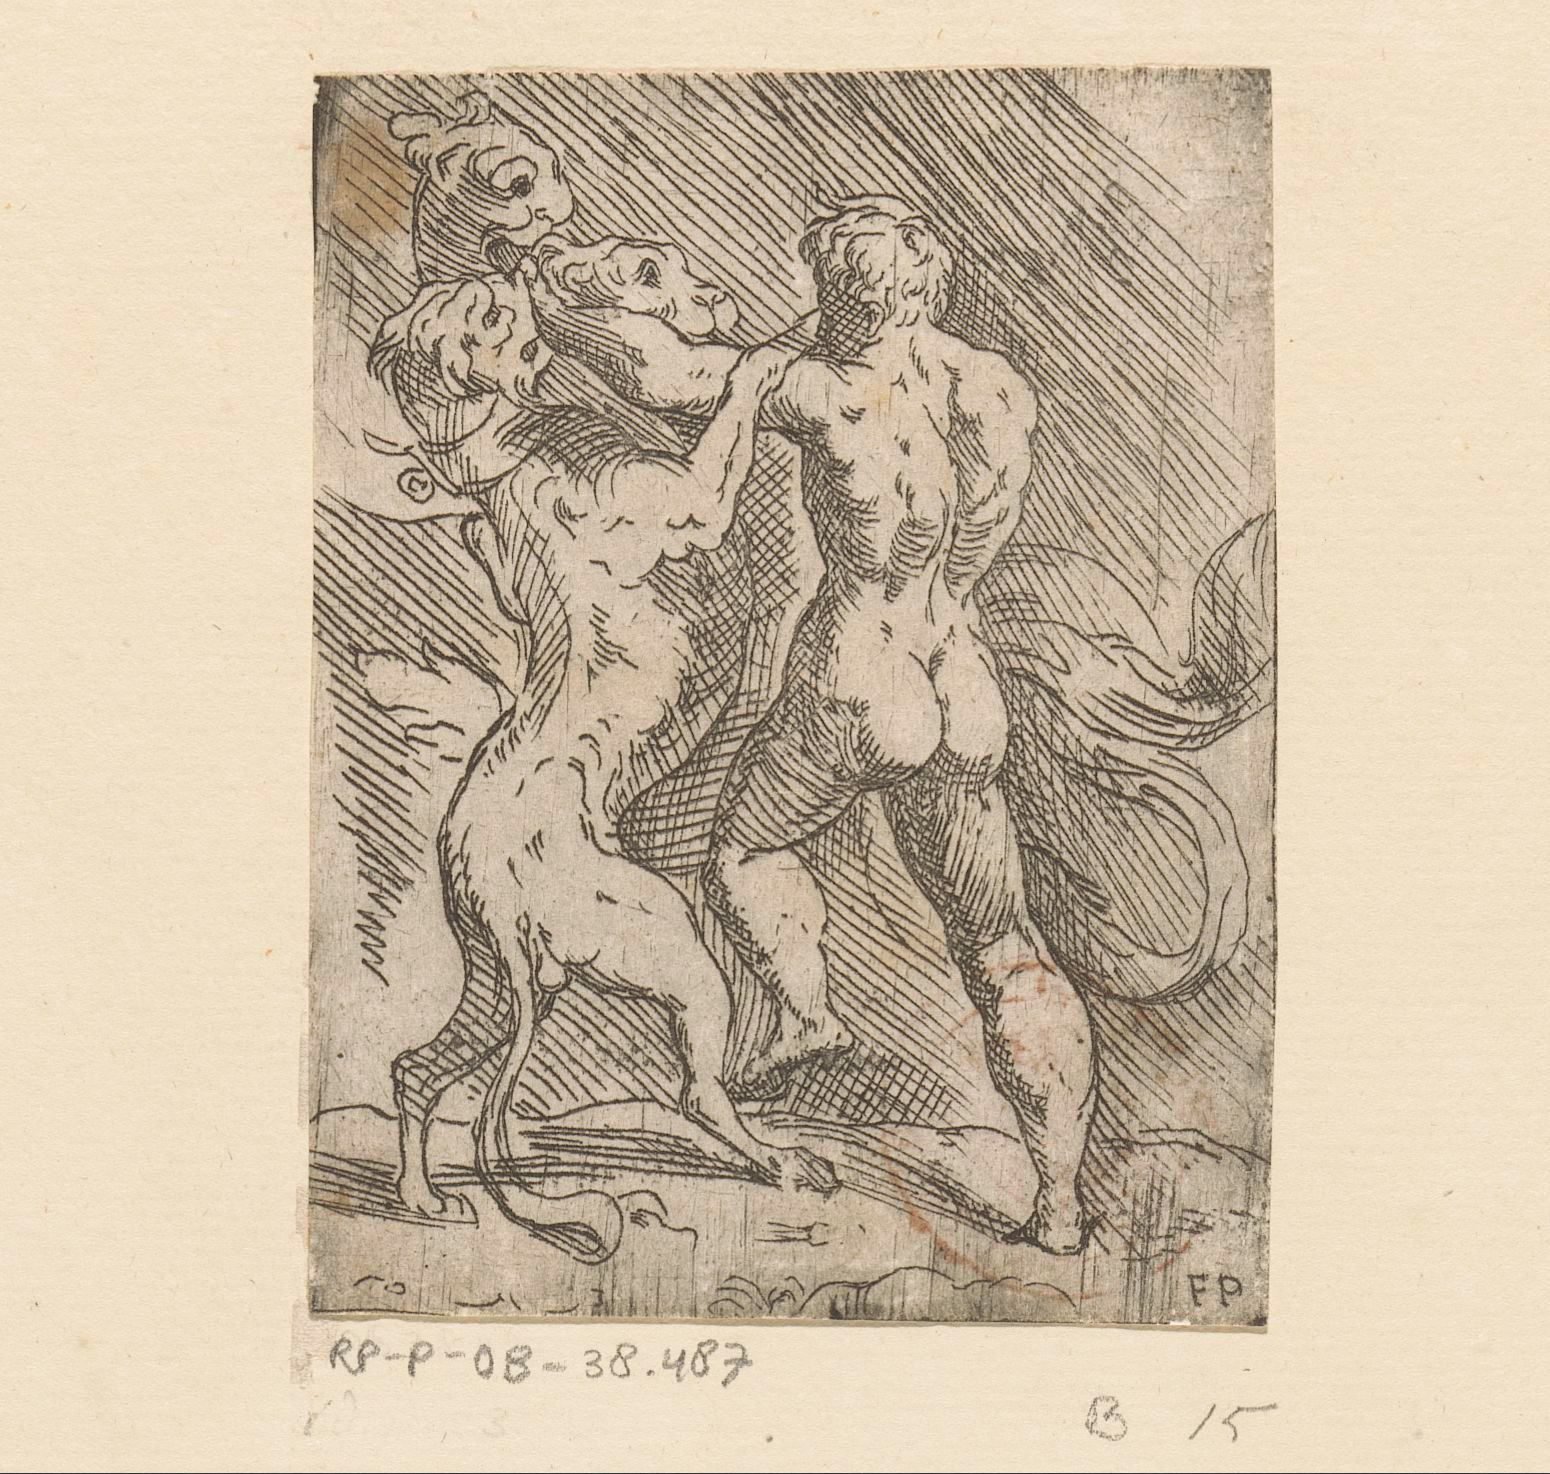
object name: print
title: Hercules in gevecht met Cerberus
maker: monogrammist fp (italië; 16e eeuw)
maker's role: print maker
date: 1500-1599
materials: paper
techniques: etching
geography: italy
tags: hercules encounters various persons in hades, cerberus, the three- or many-headed dog; 'cerbero' (ripa)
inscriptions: collector's mark: Lugt 240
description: Hercules in gevecht met de driekoppige hond Cerberus die de ingang van de onderwereld bewaakt.